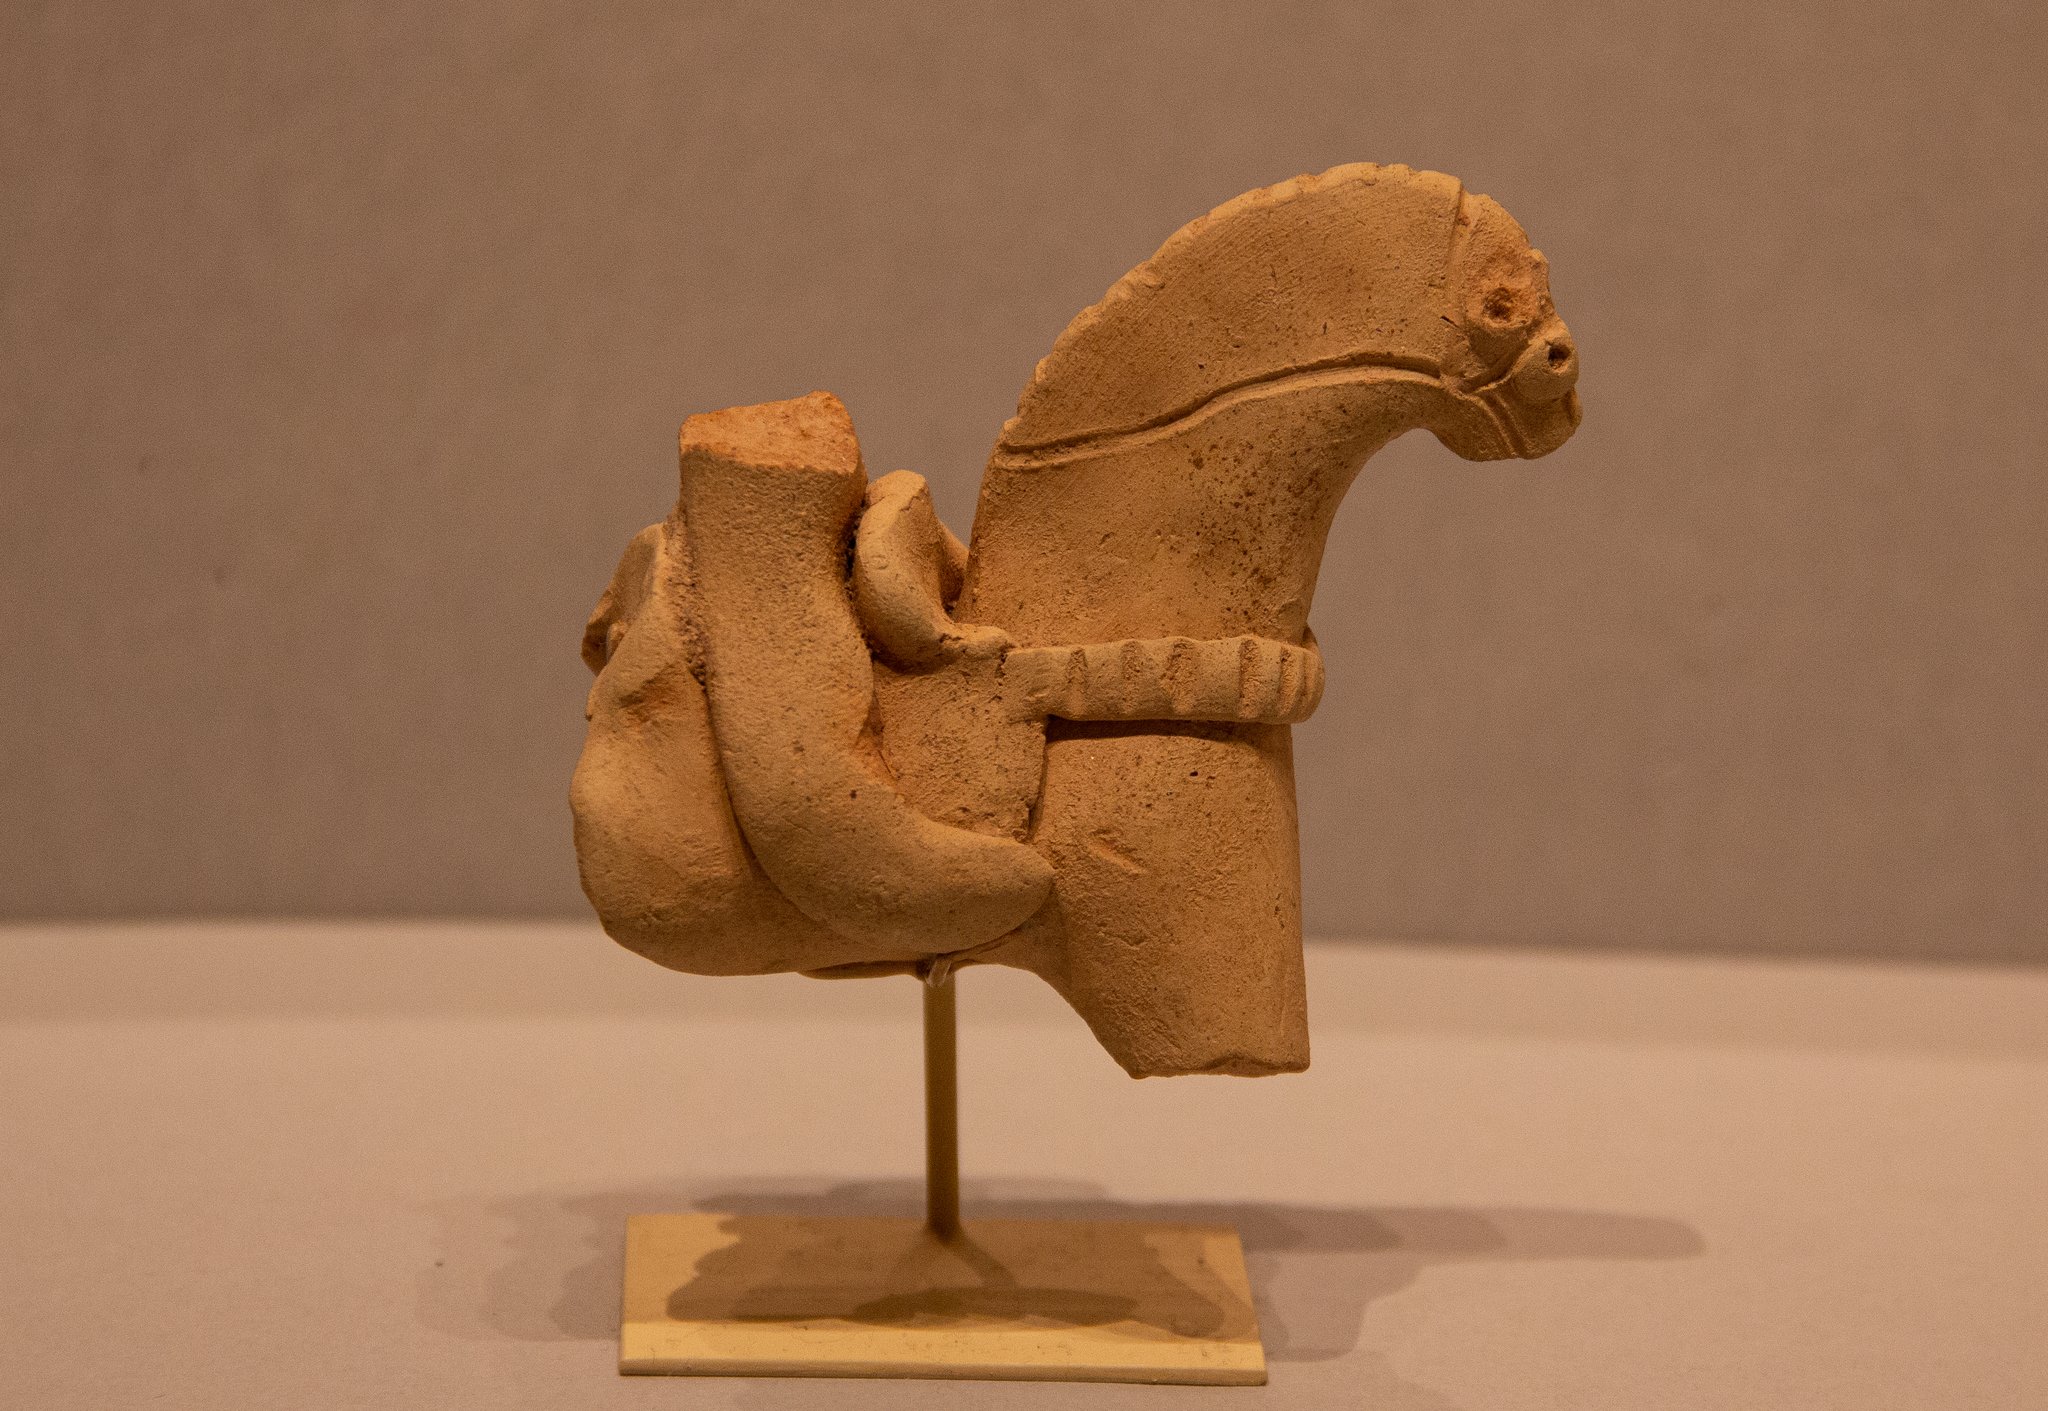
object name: model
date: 801-900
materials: earthenware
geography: iran